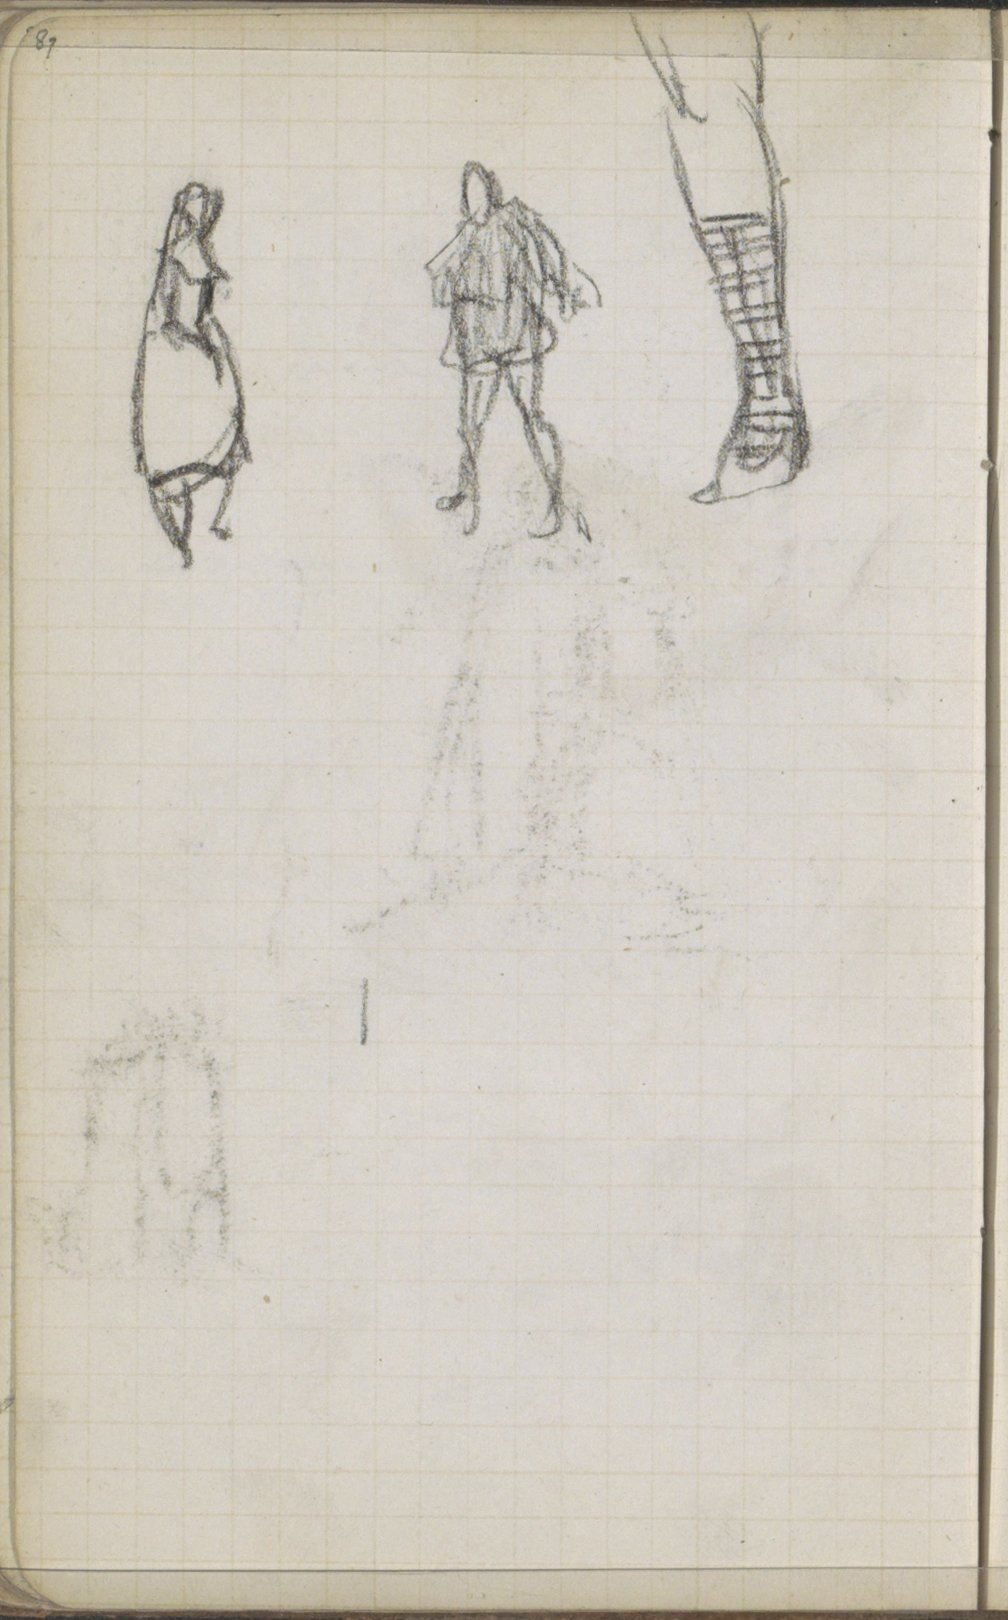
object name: sketchbook leaf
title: Man en vrouw in historisch kostuum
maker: marius bauer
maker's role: draughtsman, print maker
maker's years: 1867-1932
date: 1879-1885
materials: chalk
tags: standing figure, lower leg, adult woman, adult man, historical costume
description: Tevens een studie van een been. Pagina 87 uit een schetsboek met 58 bladen.